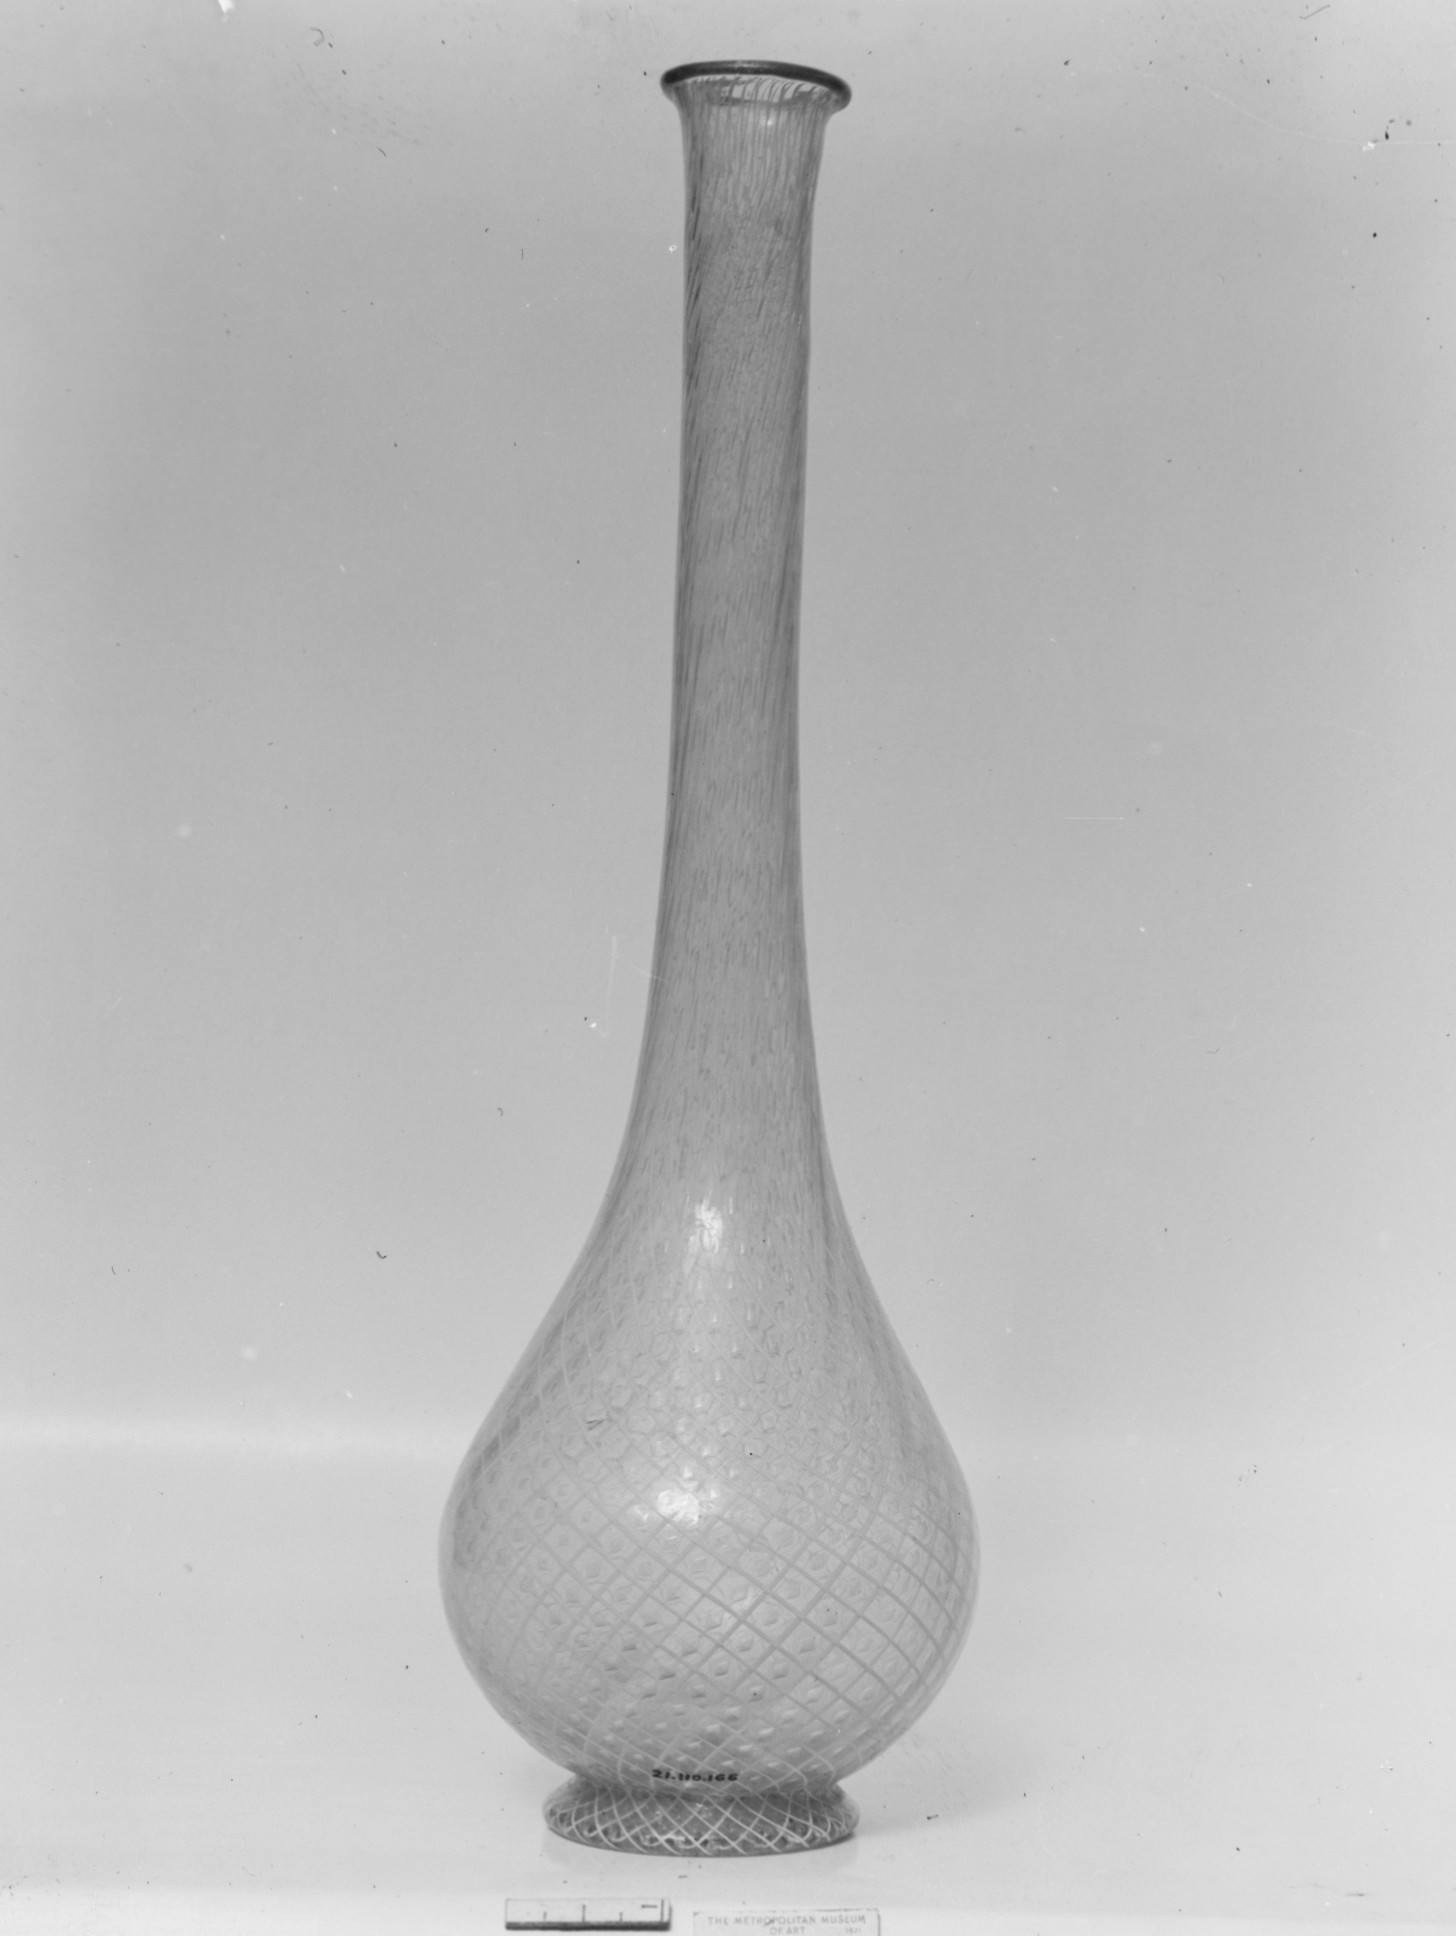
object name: bottle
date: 1601-1800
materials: glass